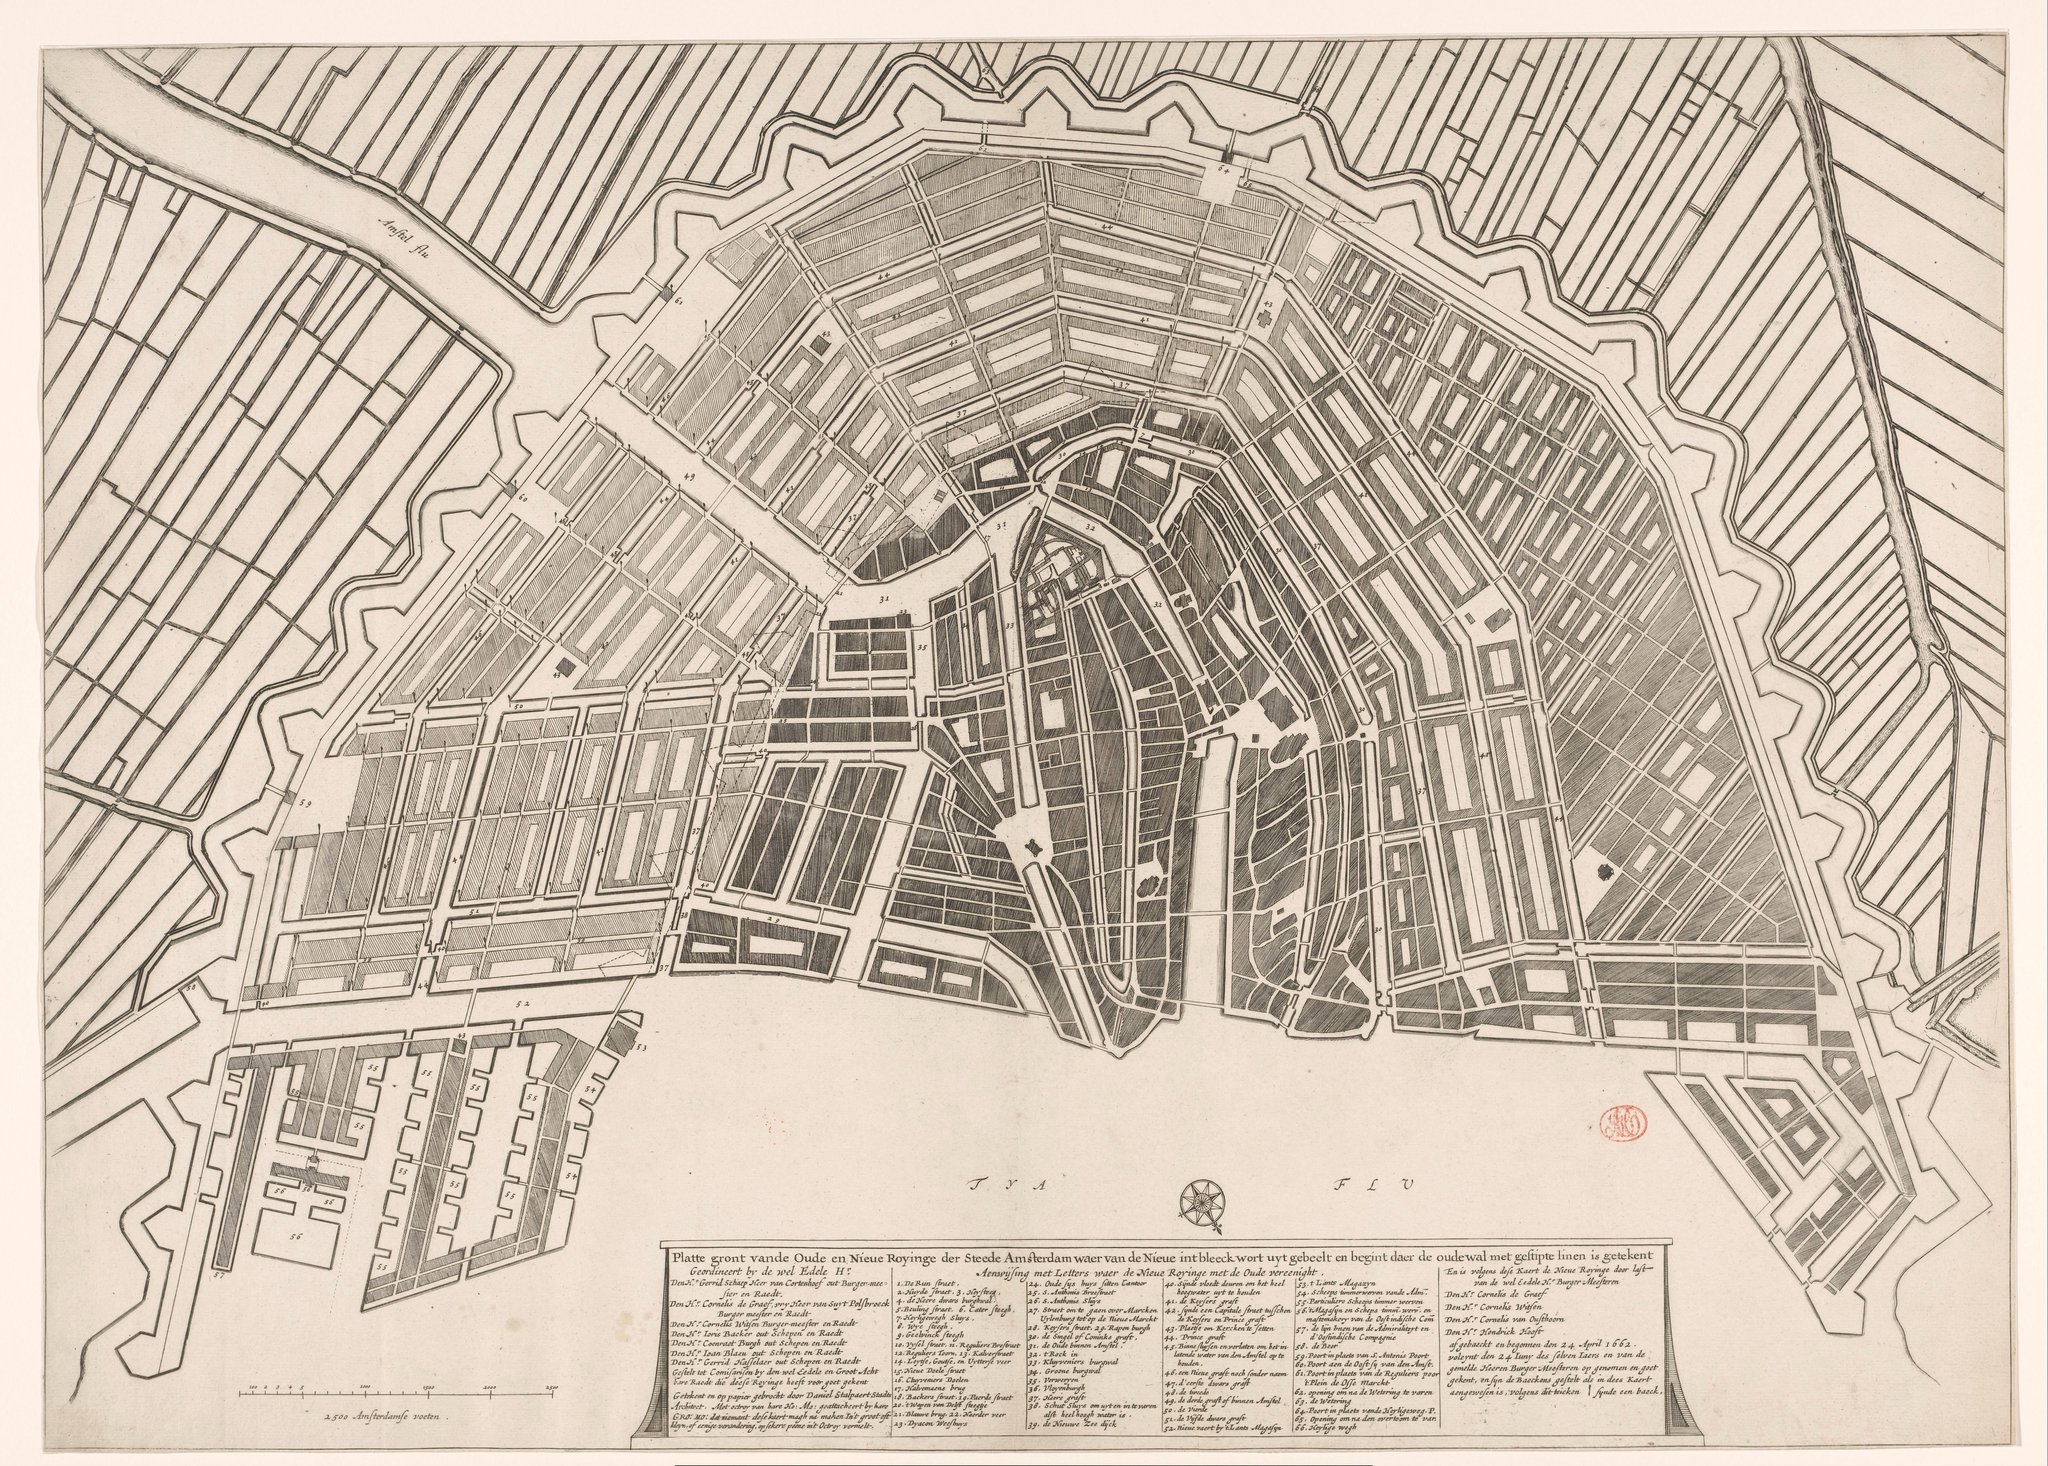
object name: print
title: Platte gront vande Oude en Nieue Royinge der Steede Amsterdam waer van de Nieue int bleeck wort uyt gebeelt en begint daer de oudewal met gestipte linen is getekent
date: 1662-1663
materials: paper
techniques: engraving, etching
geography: amsterdam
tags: maps of cities, amsterdam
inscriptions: collector's mark: Lugt 195